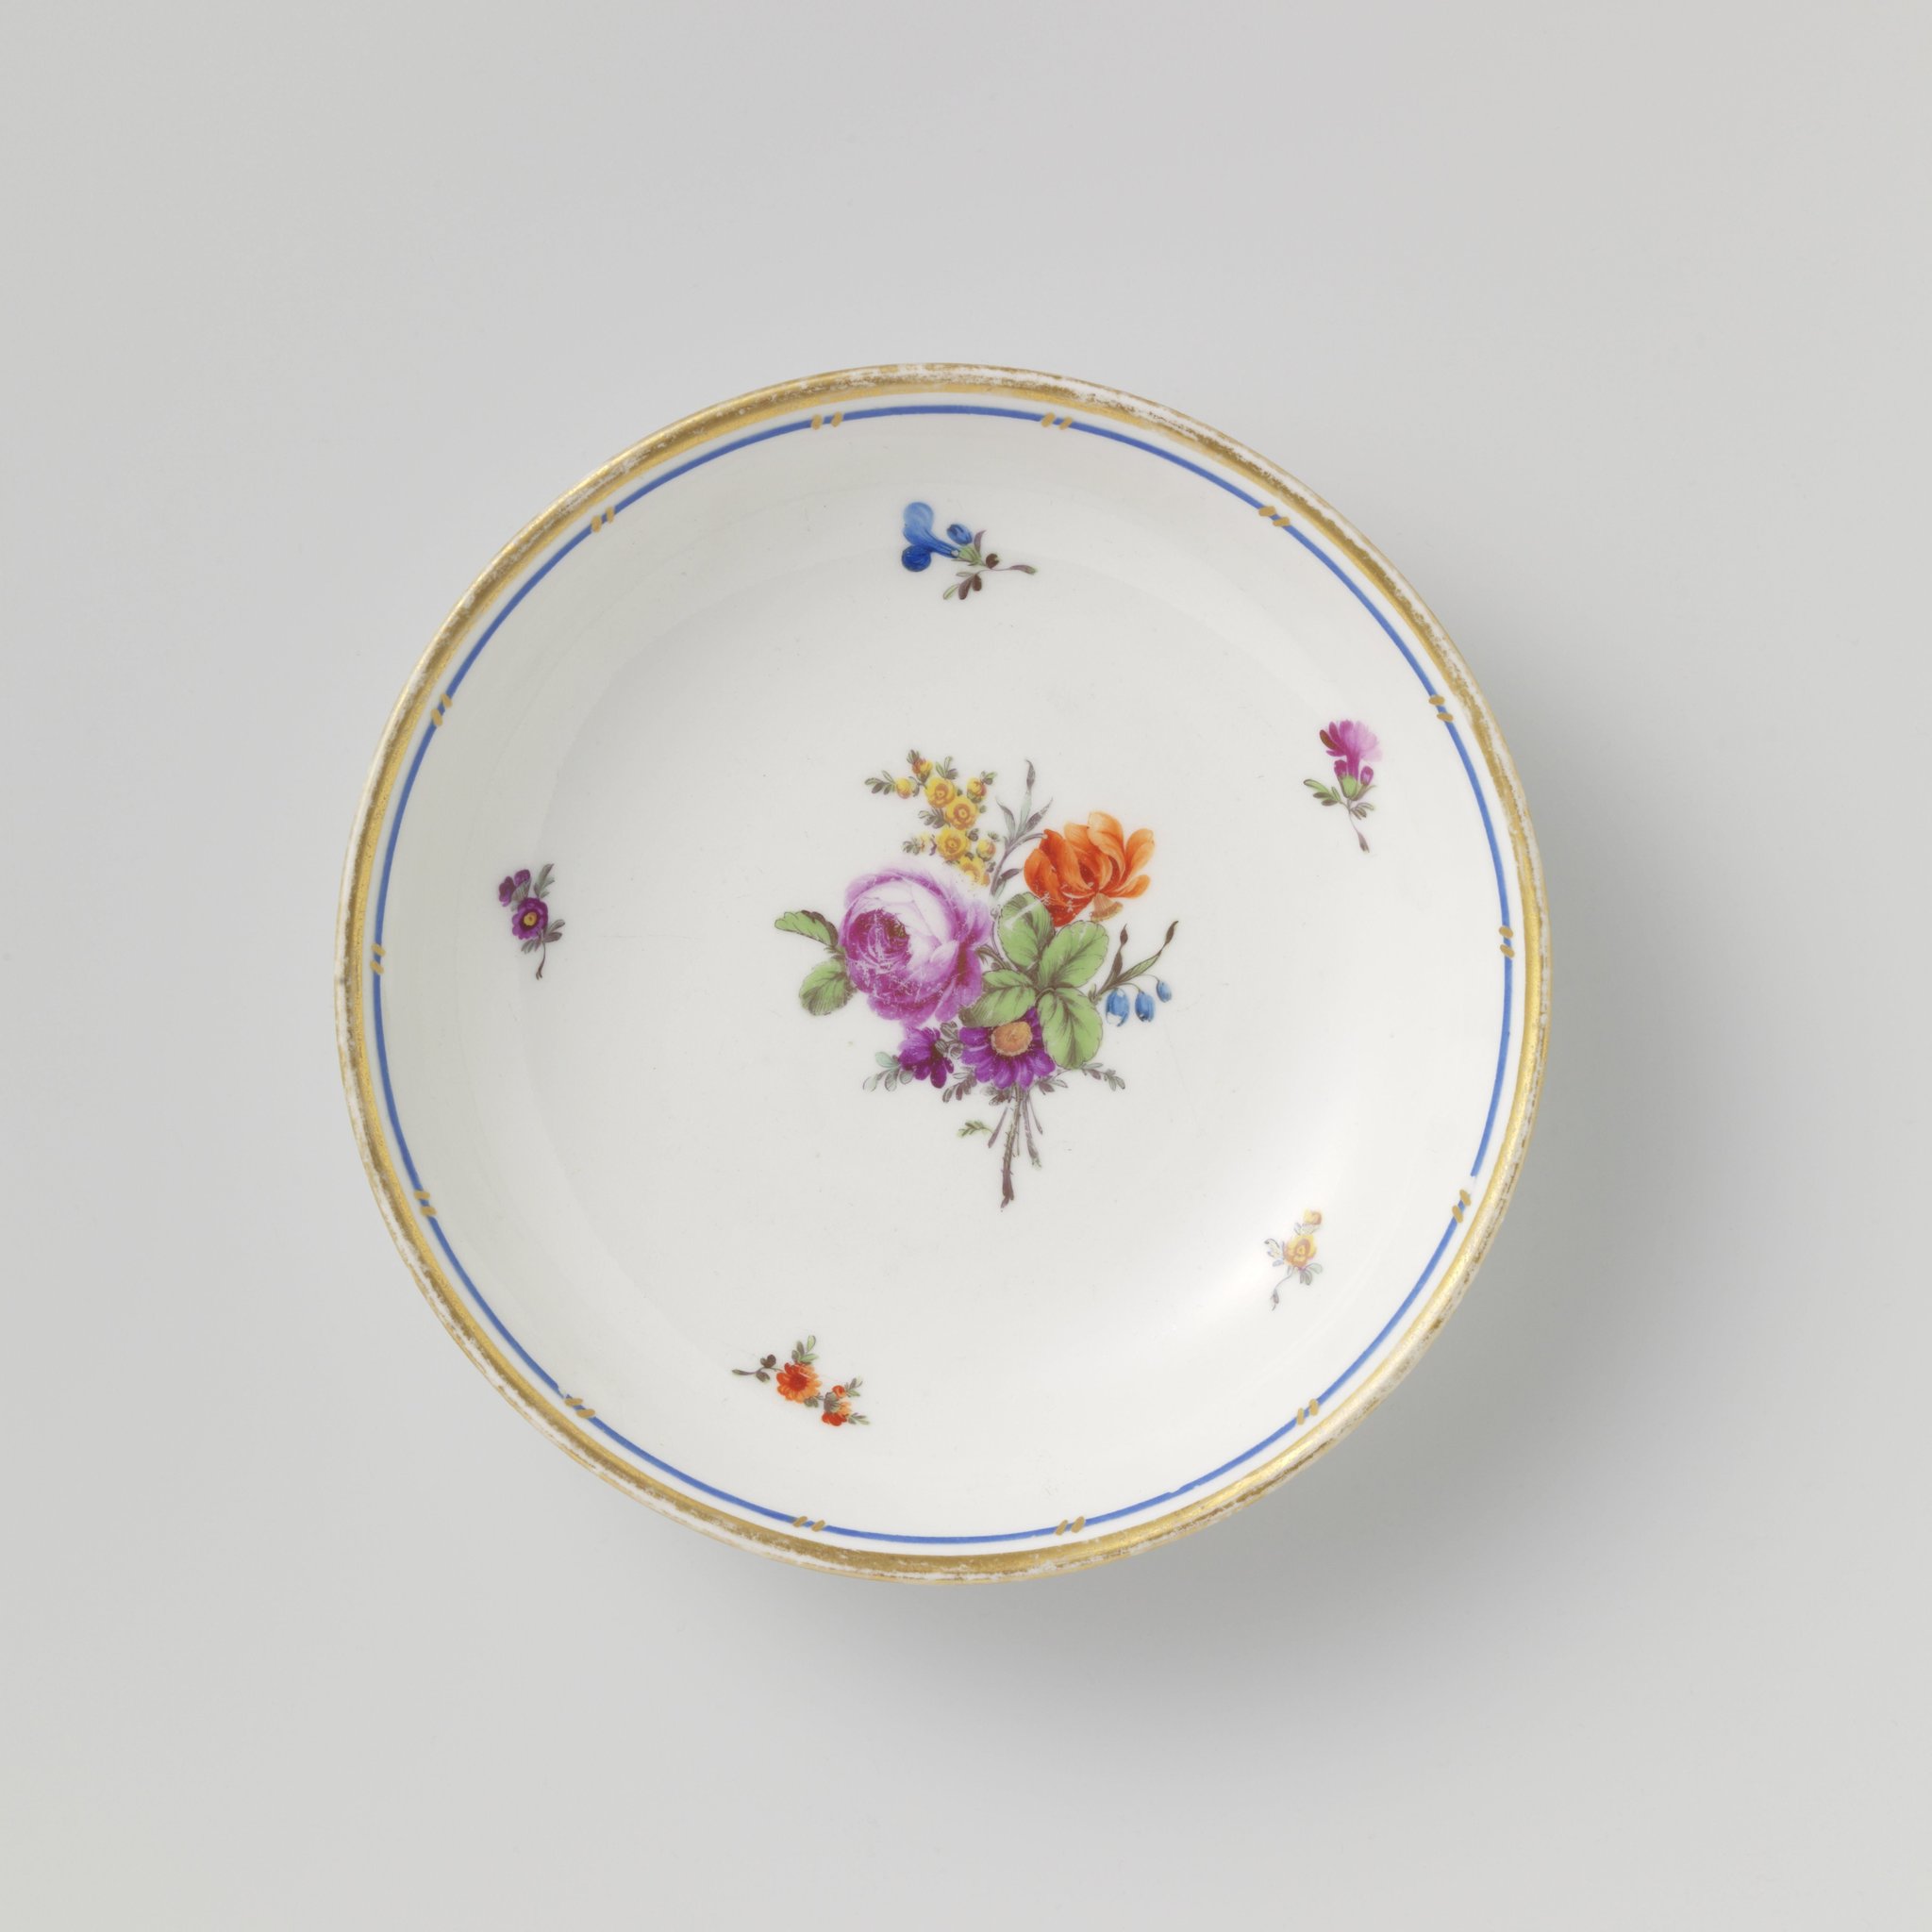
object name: cup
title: Cup with bouquets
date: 1791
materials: glaze, gold, paint, porcelain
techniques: firing, forming, gilding, turning, vitrification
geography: vienna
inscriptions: mark: ‘schild/ 44, 21, 91’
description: Kop van porselein met een gevlochten oor, beschilderd op het glazuur in blauw, rood, roze, groen, geel, zwart en goud. Op de buitenwand een boeket van verschillende bloemen en losse bloemtakken. De rand met een blauwe lijn, onderbroken door telkens tweemaal een schuin gouden streepje. Gemerkt op de onderzijde met het schild, de nummers 21, 44 en het jaarnummer 91.